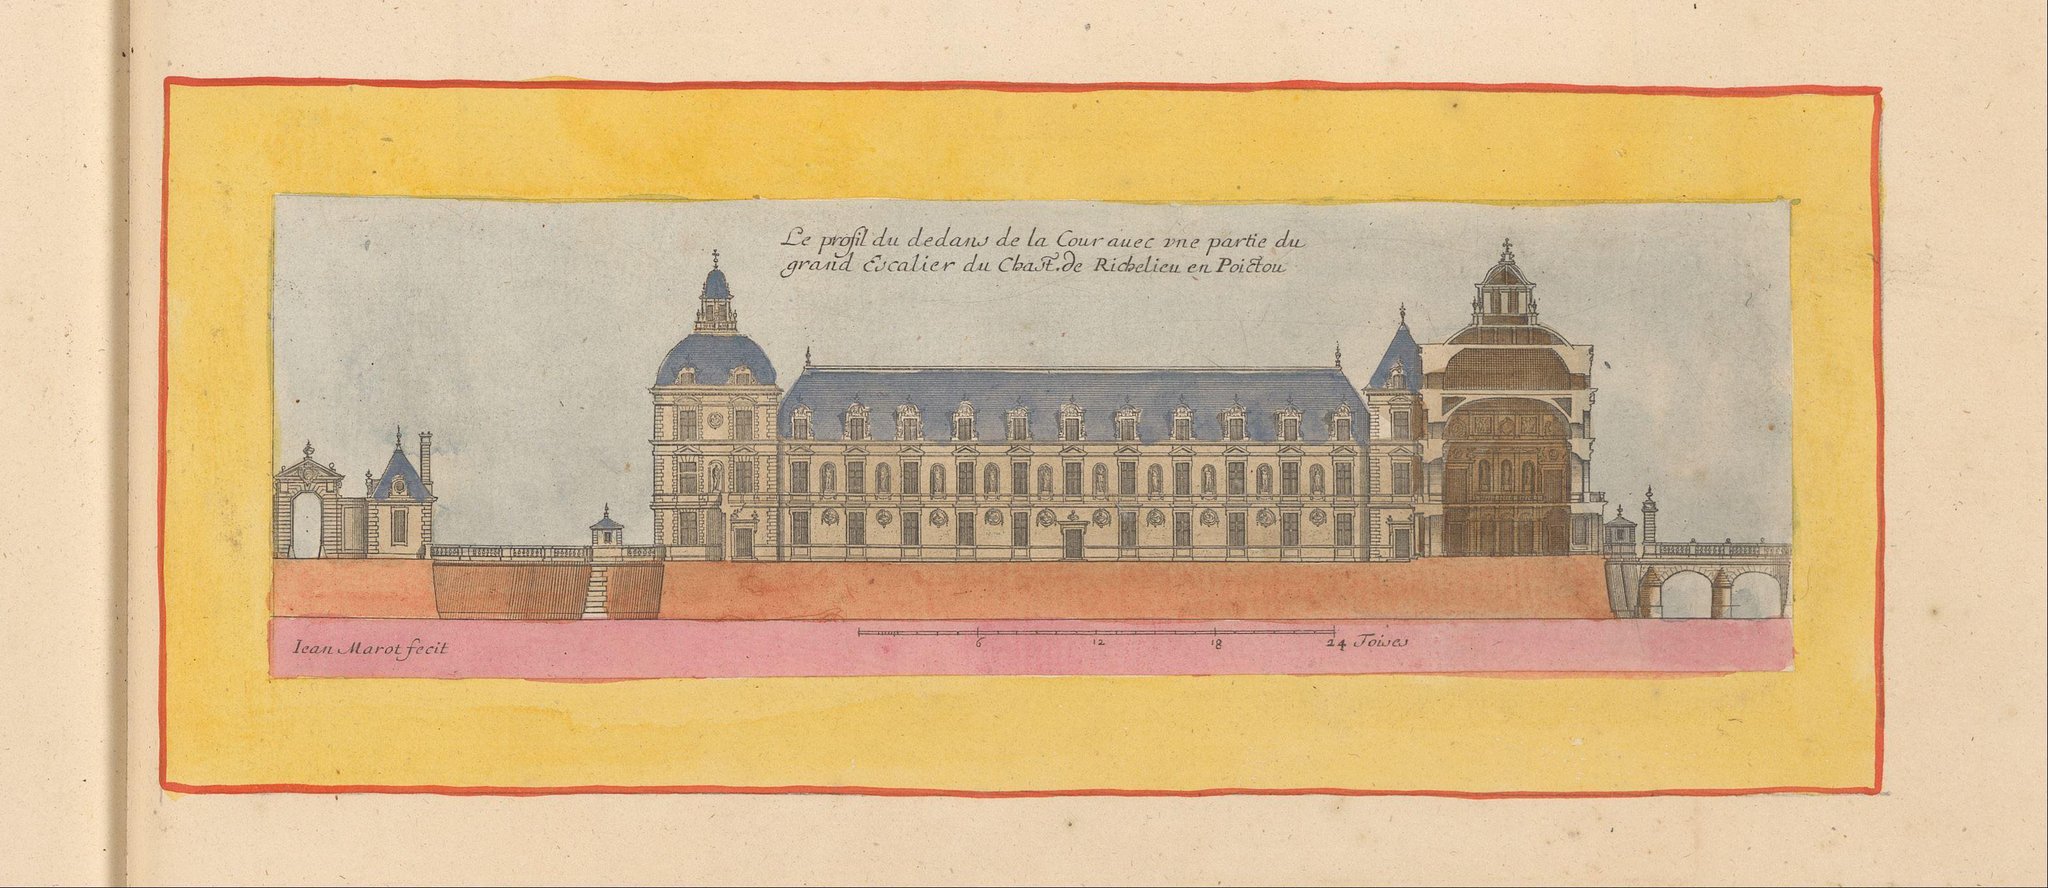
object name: print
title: Le magnifique chasteau de Richelieu, ou les plans, les fassades, les elevations et profils du dit chasteau (...)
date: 1629-1679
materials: paper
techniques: etching, hand coloring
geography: the hague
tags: castle, series of designs, models, etc. of one architectural project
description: Deze prent maakt deel uit van een album.